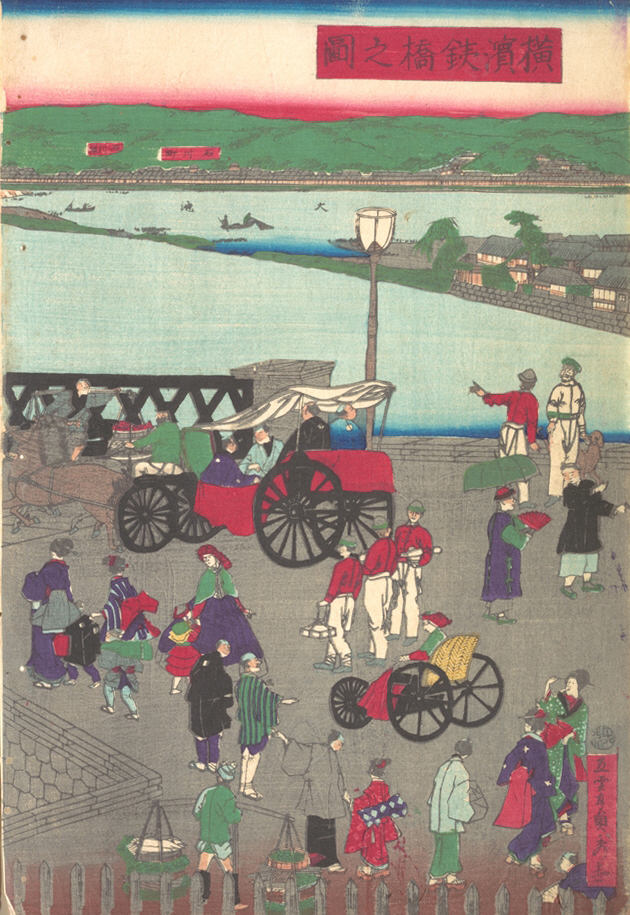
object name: print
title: The Steel Bridge at Yokohama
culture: japanese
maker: utagawa (gountei) sadahide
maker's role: artist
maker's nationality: japanese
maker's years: 1807-1873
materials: ink, paper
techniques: woodblock print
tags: bridges,men,women,horses,carriages